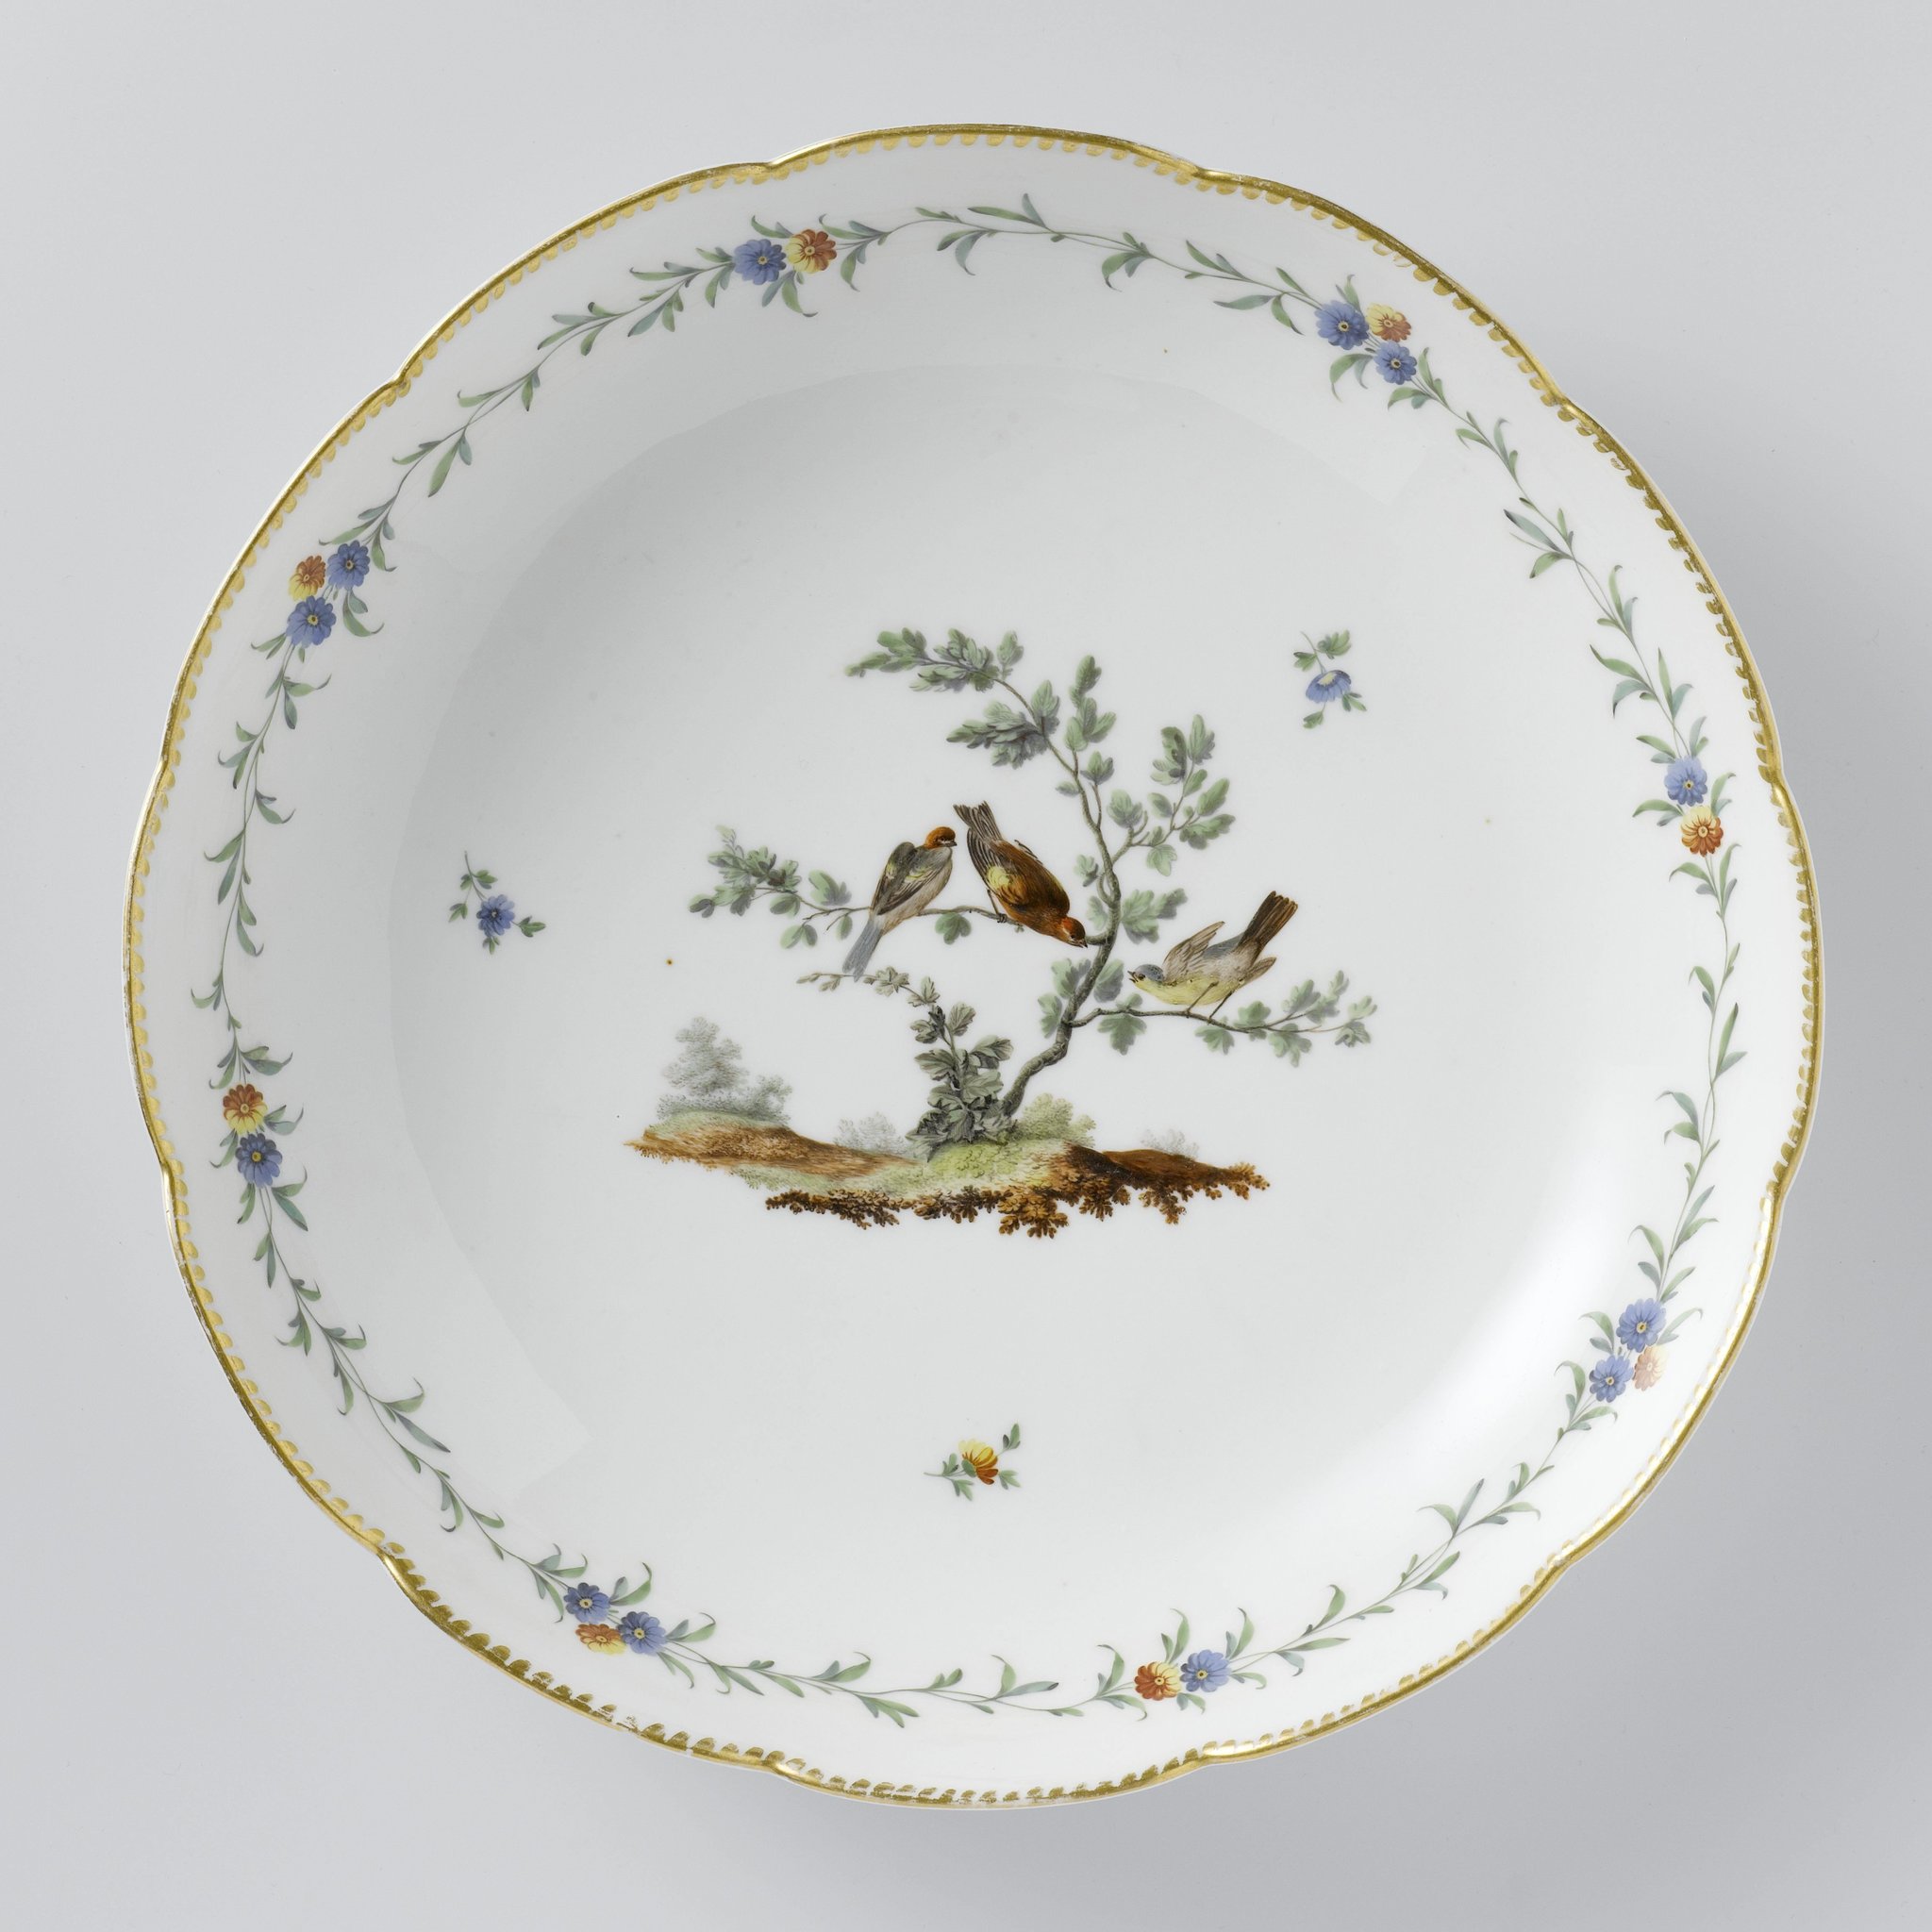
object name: dish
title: Schaal, beschilderd met drie vogels in een boom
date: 1782-1784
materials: porcelain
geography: loosdrecht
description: Dish. Porcelain. Loosdrecht, c. 1780 - 1784.